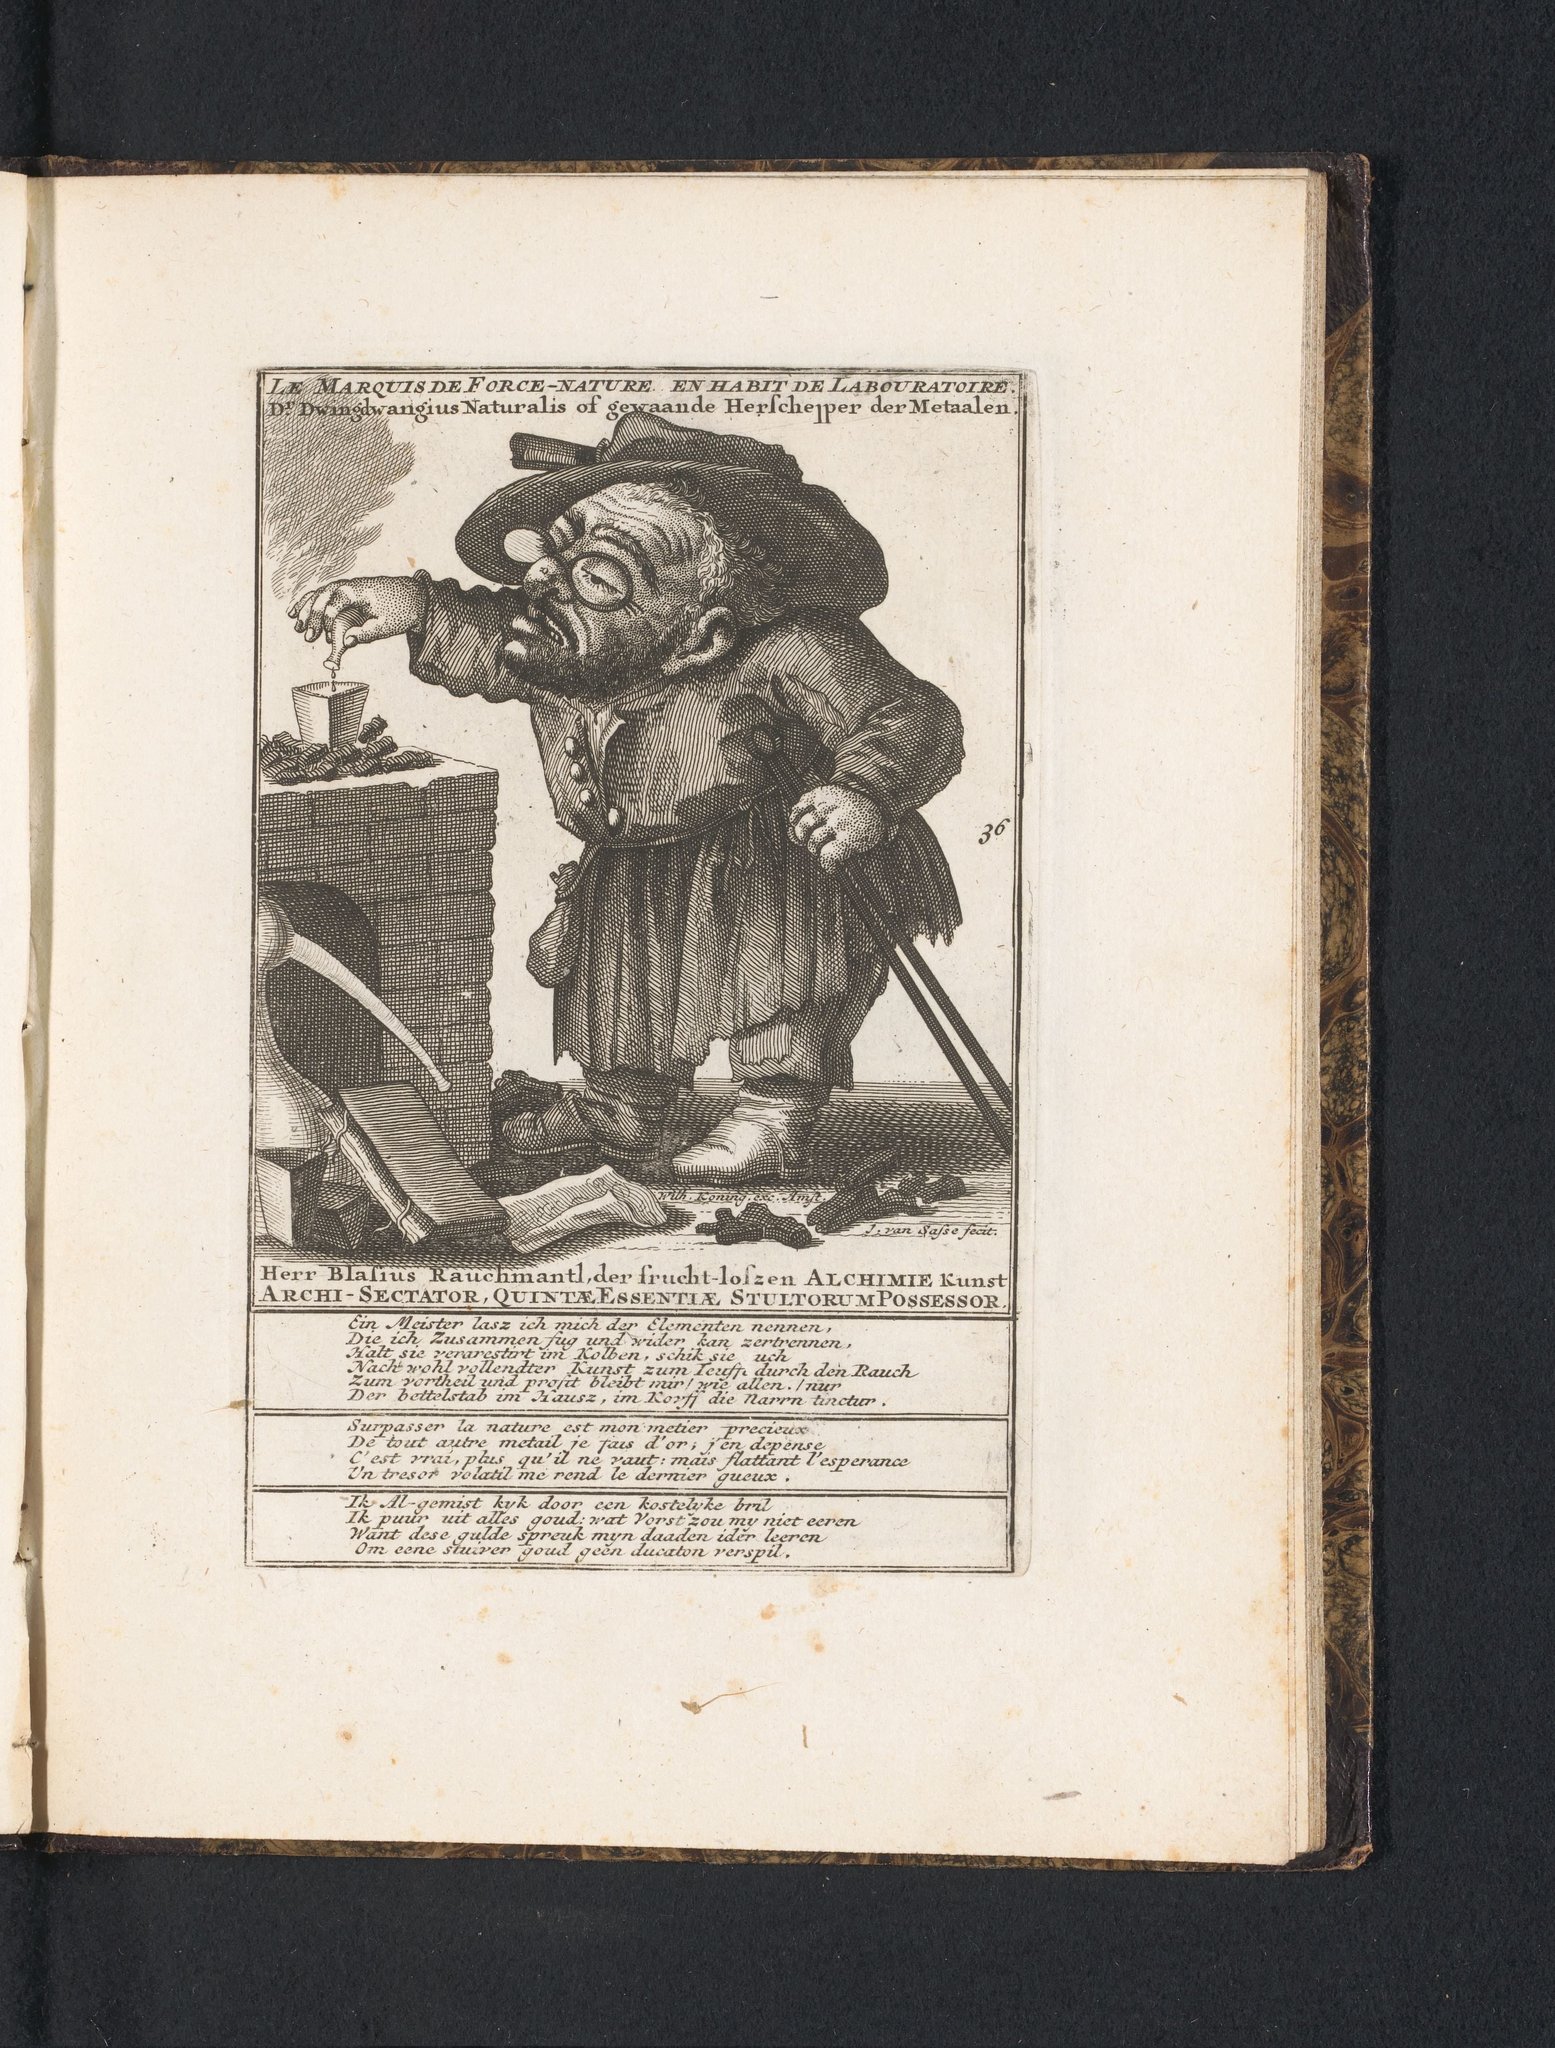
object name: print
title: De dwerg Dr. Dwingdwangius Naturalis als alchemist, 1720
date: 1718-1720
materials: paper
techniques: etching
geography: amsterdam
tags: caricatures (human types), little people, alchemist at work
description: De kleine mens Dr. Dwingdwangius Naturalis als alchemist. In het onderschrift verzen in het Duits, Frans en Nederlands. Genummerd rechts midden: 36. Onderdeel van deel II in de tweede Nederlandse gebonden uitgave uit 1720 (en gerelateerd aan de Windhandel in dat jaar) van een serie karikaturen van kleine mensen, bekend als Het Dwergentooneel.